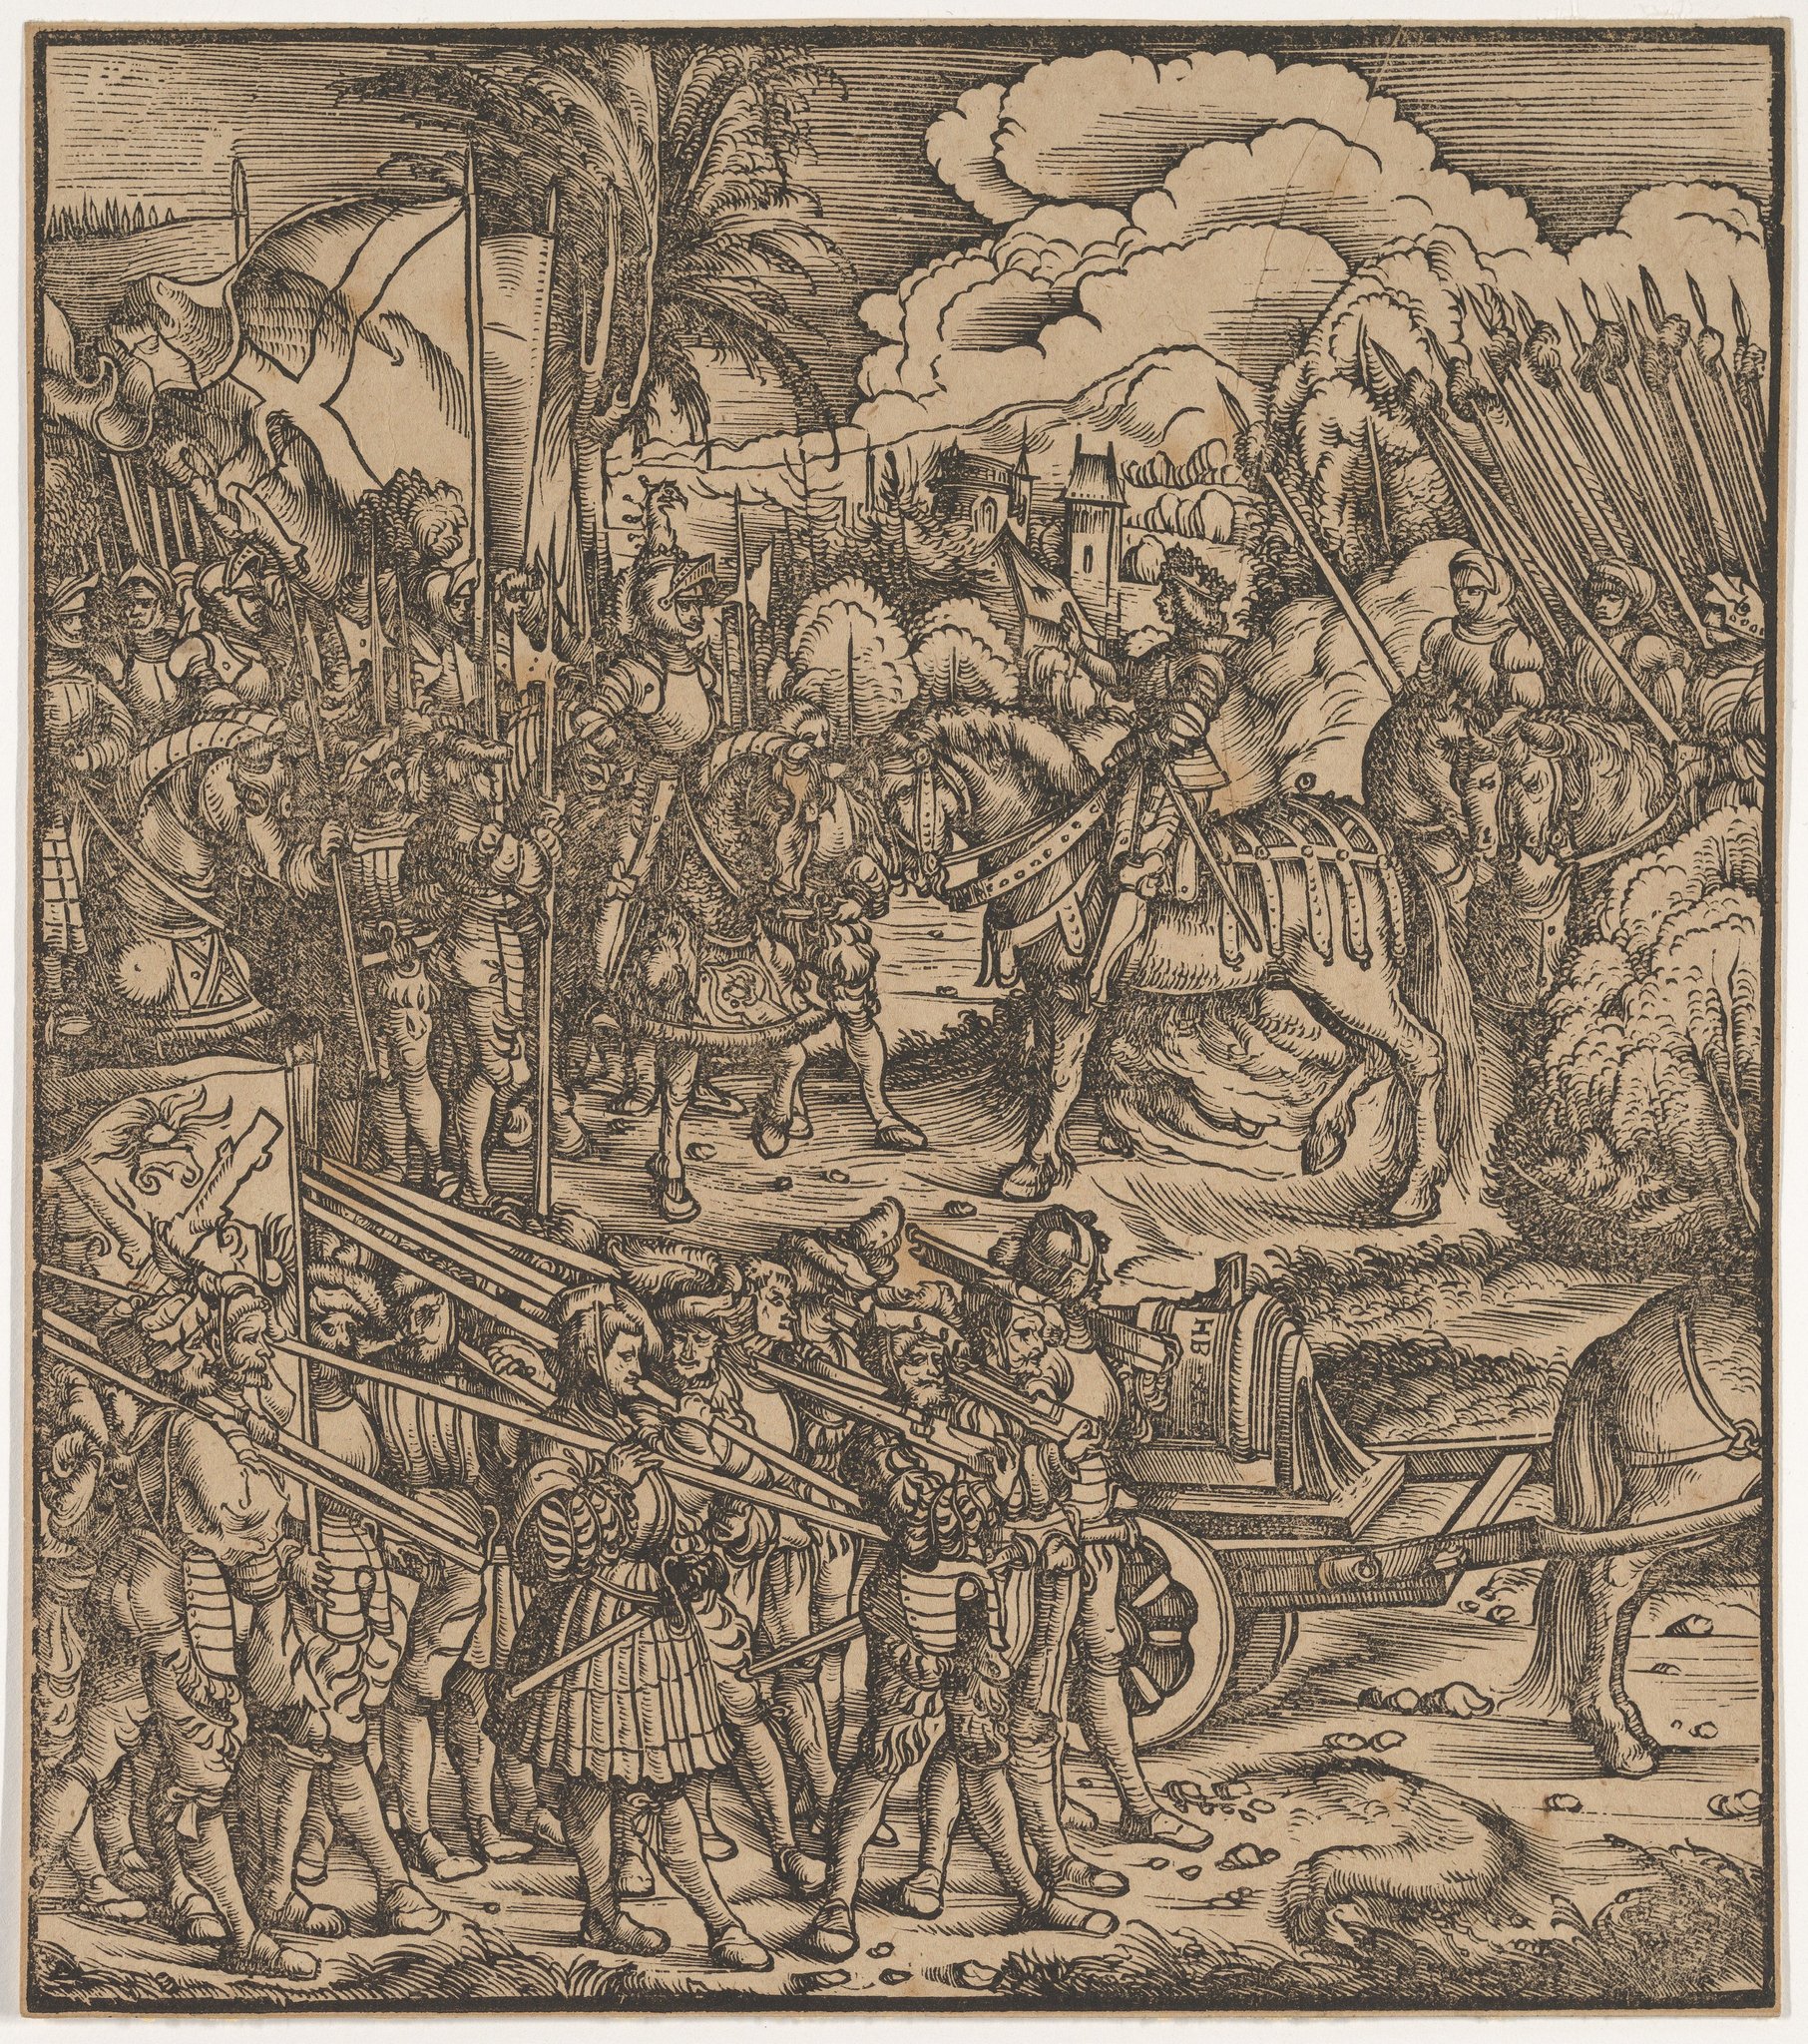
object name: print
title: Encounter of Two Generals Before Cleves, from "Der Weisskunig"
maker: hans burgkmair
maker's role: artist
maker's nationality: german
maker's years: 1473-1531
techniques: woodcut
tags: soldiers,cannons,men,horses